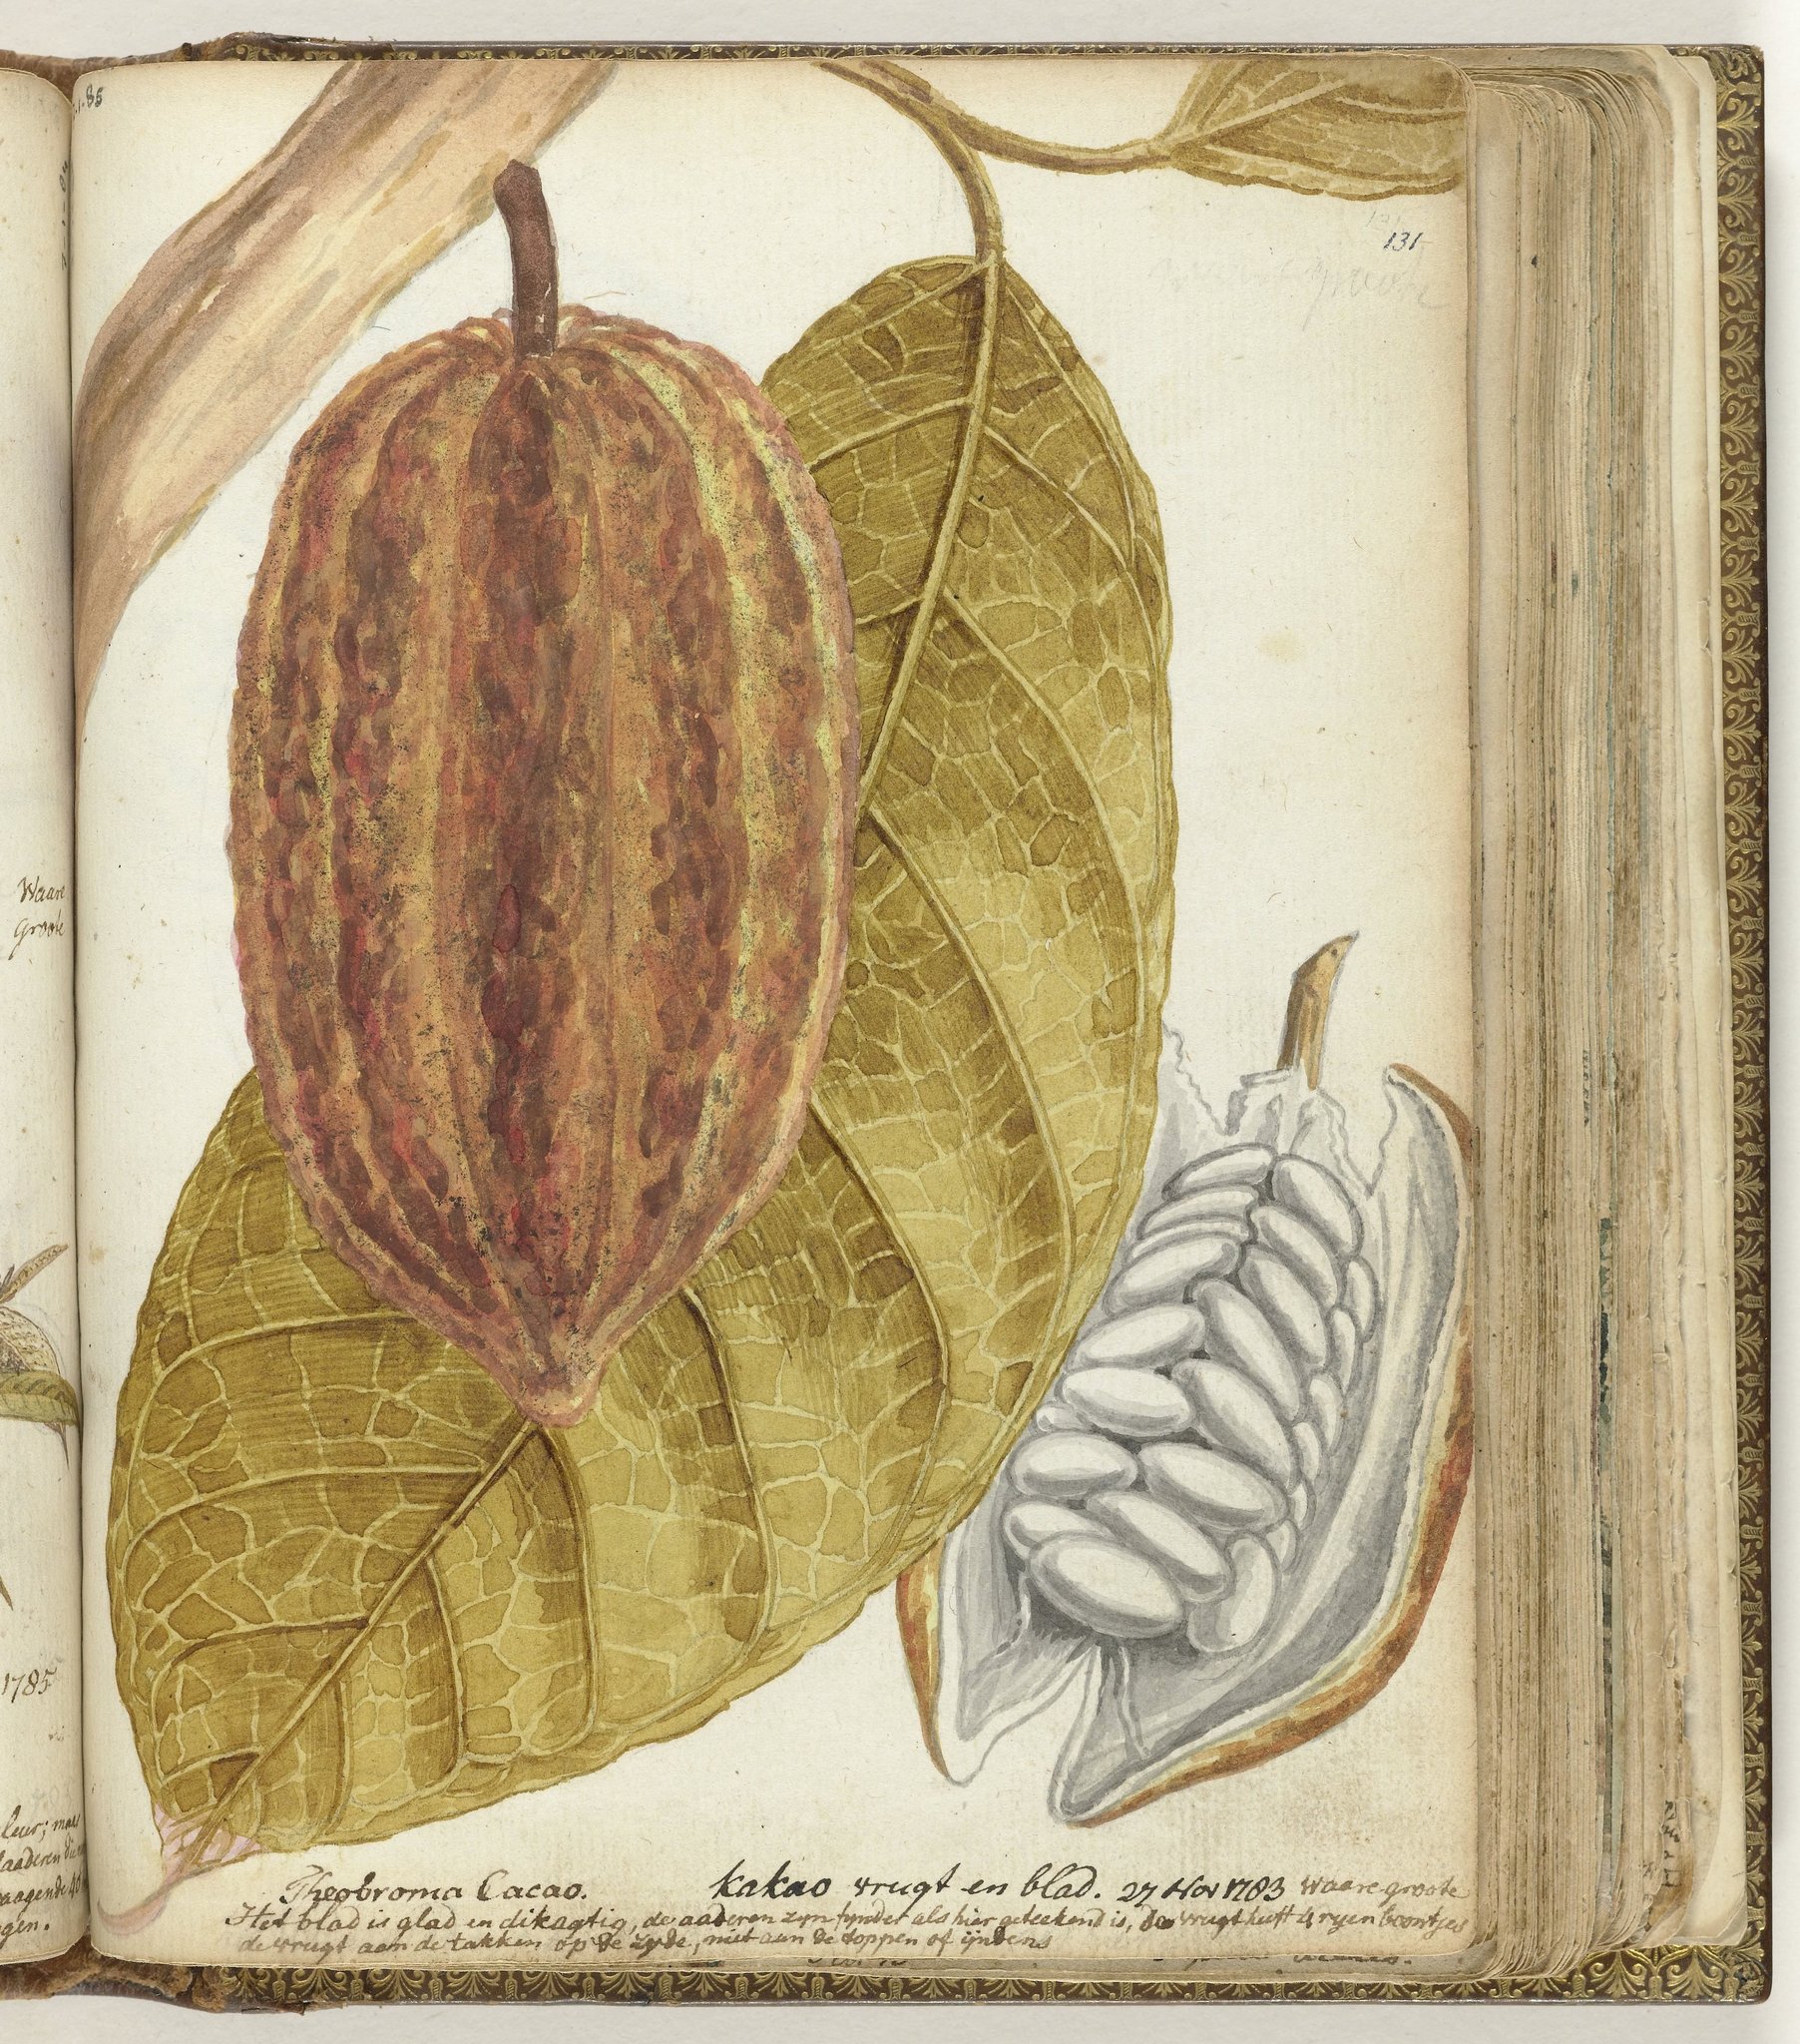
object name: drawing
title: Cacao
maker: jan brandes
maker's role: draughtsman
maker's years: 1743-1808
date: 1783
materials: paper, pencil, watercolor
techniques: brush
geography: jakarta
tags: fruits: cacao, java, batavia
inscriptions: inscription: ‘Theobroma Cacao Kakao vrugt en blad. 27 Nov 1783 Waare groote Het blad is glad en dikagtig, de aaderen zyn fynder als hier geteekend is, de vrugt heeft 4 ryen boontjes de vrugt aan de takken op de zyde, niet aan de toppen of ijndens’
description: Kleurtekening van de cacaovrucht, blad en de vrucht met gebroken schil zodat de cacaobonen zichtbaar zijn. Op ware grootte. Met opschrift. Onderdeel uit het schetsboek van Jan Brandes, dl. 1 (1808), p. 131.